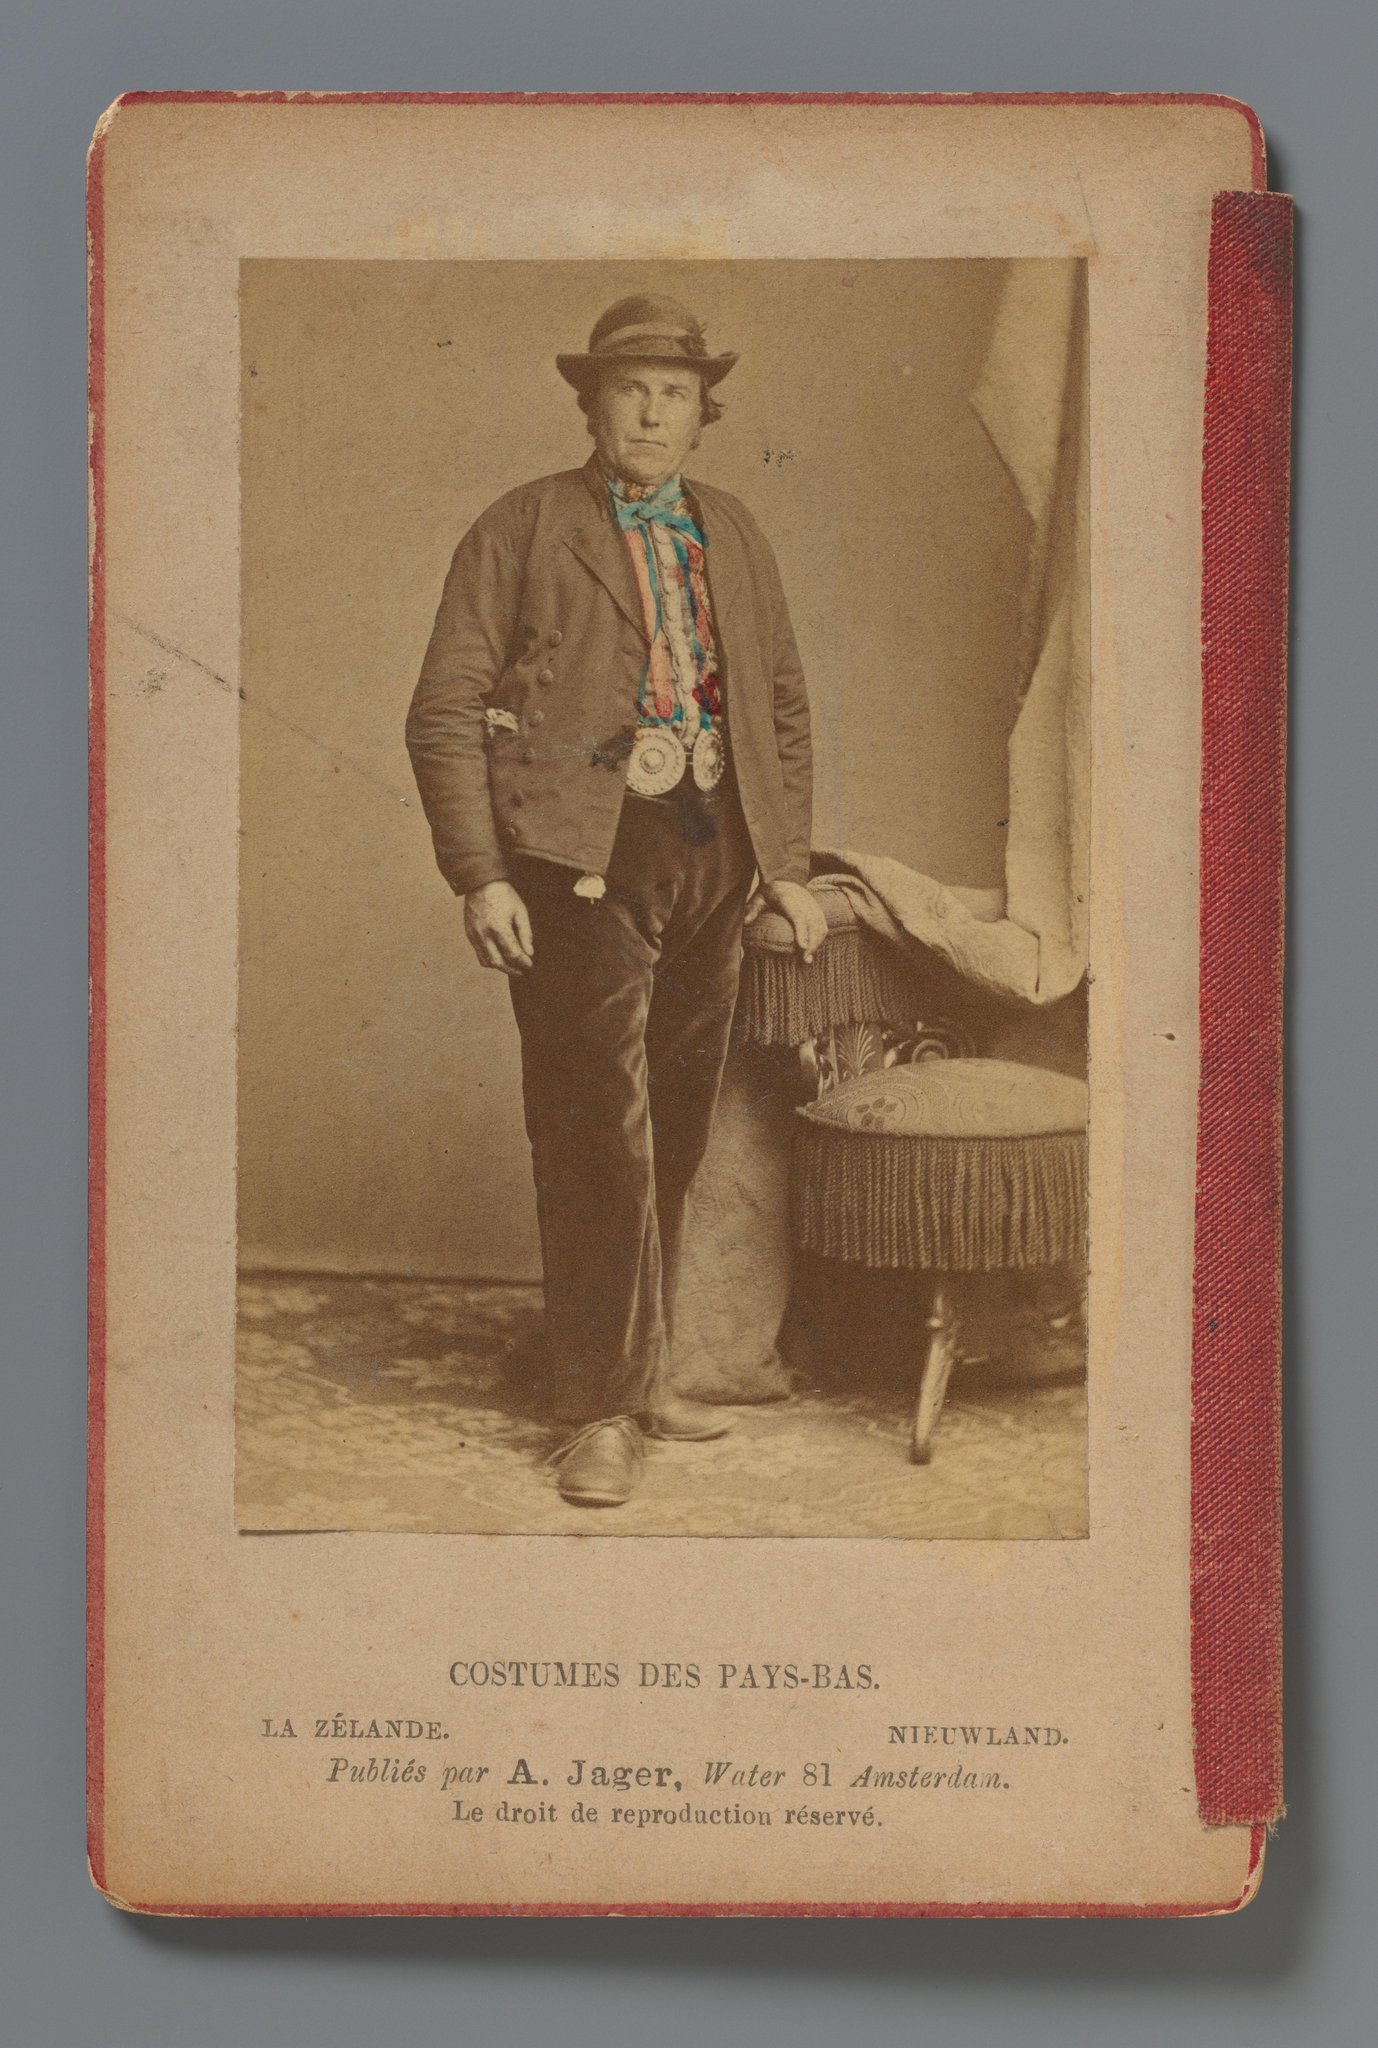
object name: photograph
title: Portret van een onbekende man uit Zeeland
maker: andries jager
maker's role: publisher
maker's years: 1825-1905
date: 1855-1870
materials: cardboard, linen, paper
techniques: albumen print, hand coloring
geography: amsterdam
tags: folk costume, regional costume, historical persons not known by name, zeeland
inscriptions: inscription: ‘Le droit de reproduction réservé.’